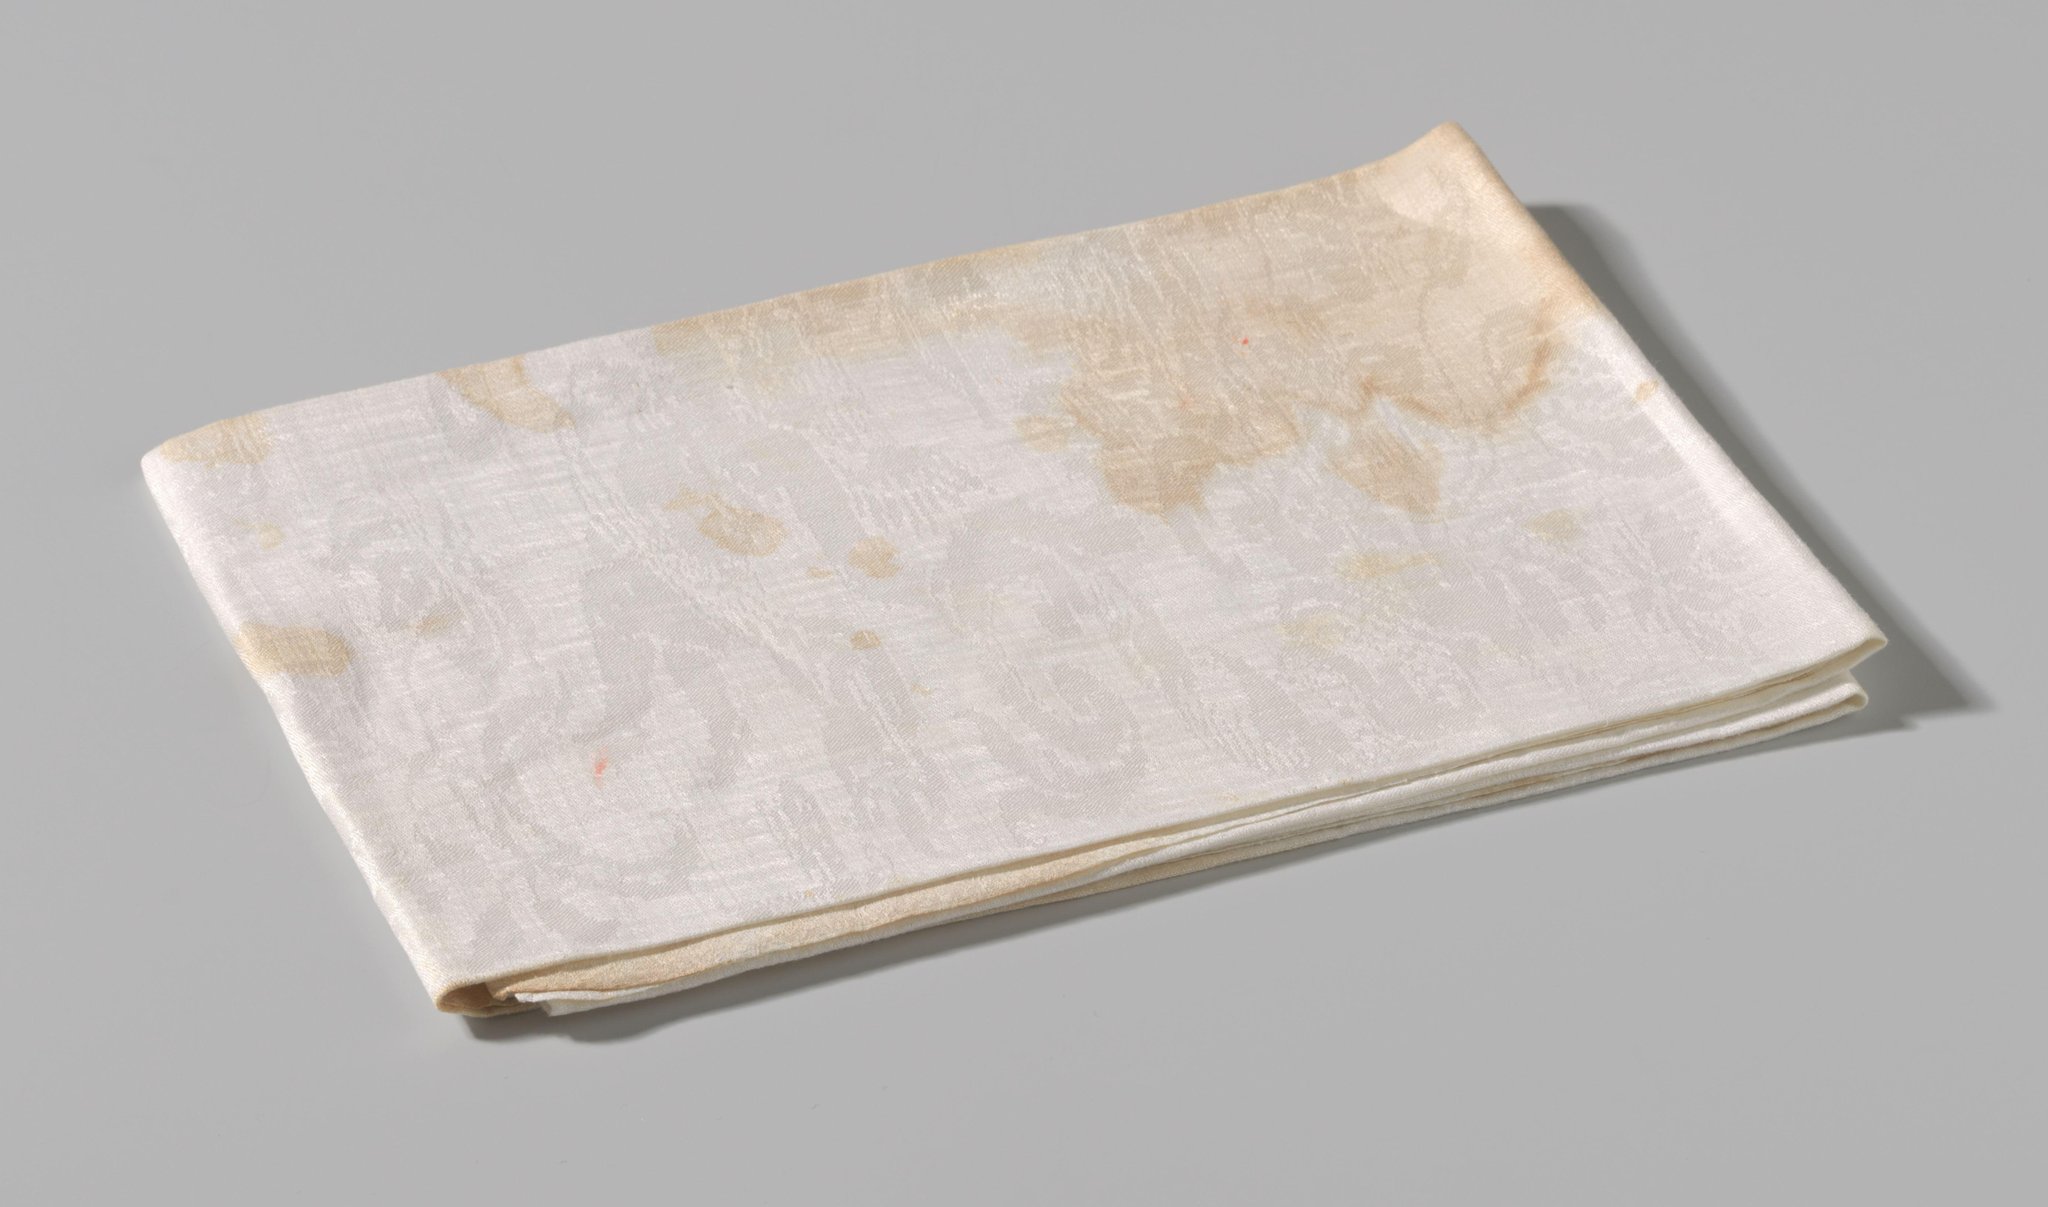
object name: napkin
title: Servet van linnendamast met putti en bloemen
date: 1660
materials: linen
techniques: damask, weave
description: Servet van linnendamast. Het patroon heeft bloemen en vruchten waartussen putti die hoorns des overvloed dragen en putti die een bloemenmand dragen. De lopende rand heeft een golvende lijn waartussen vogels en bloemen en een blokrand. Het servet is stukgoed, waardoor het geen liggende randen en hoeken heeft. Het servet hoort bij een tafellaken (BK-KOG-2607-A).